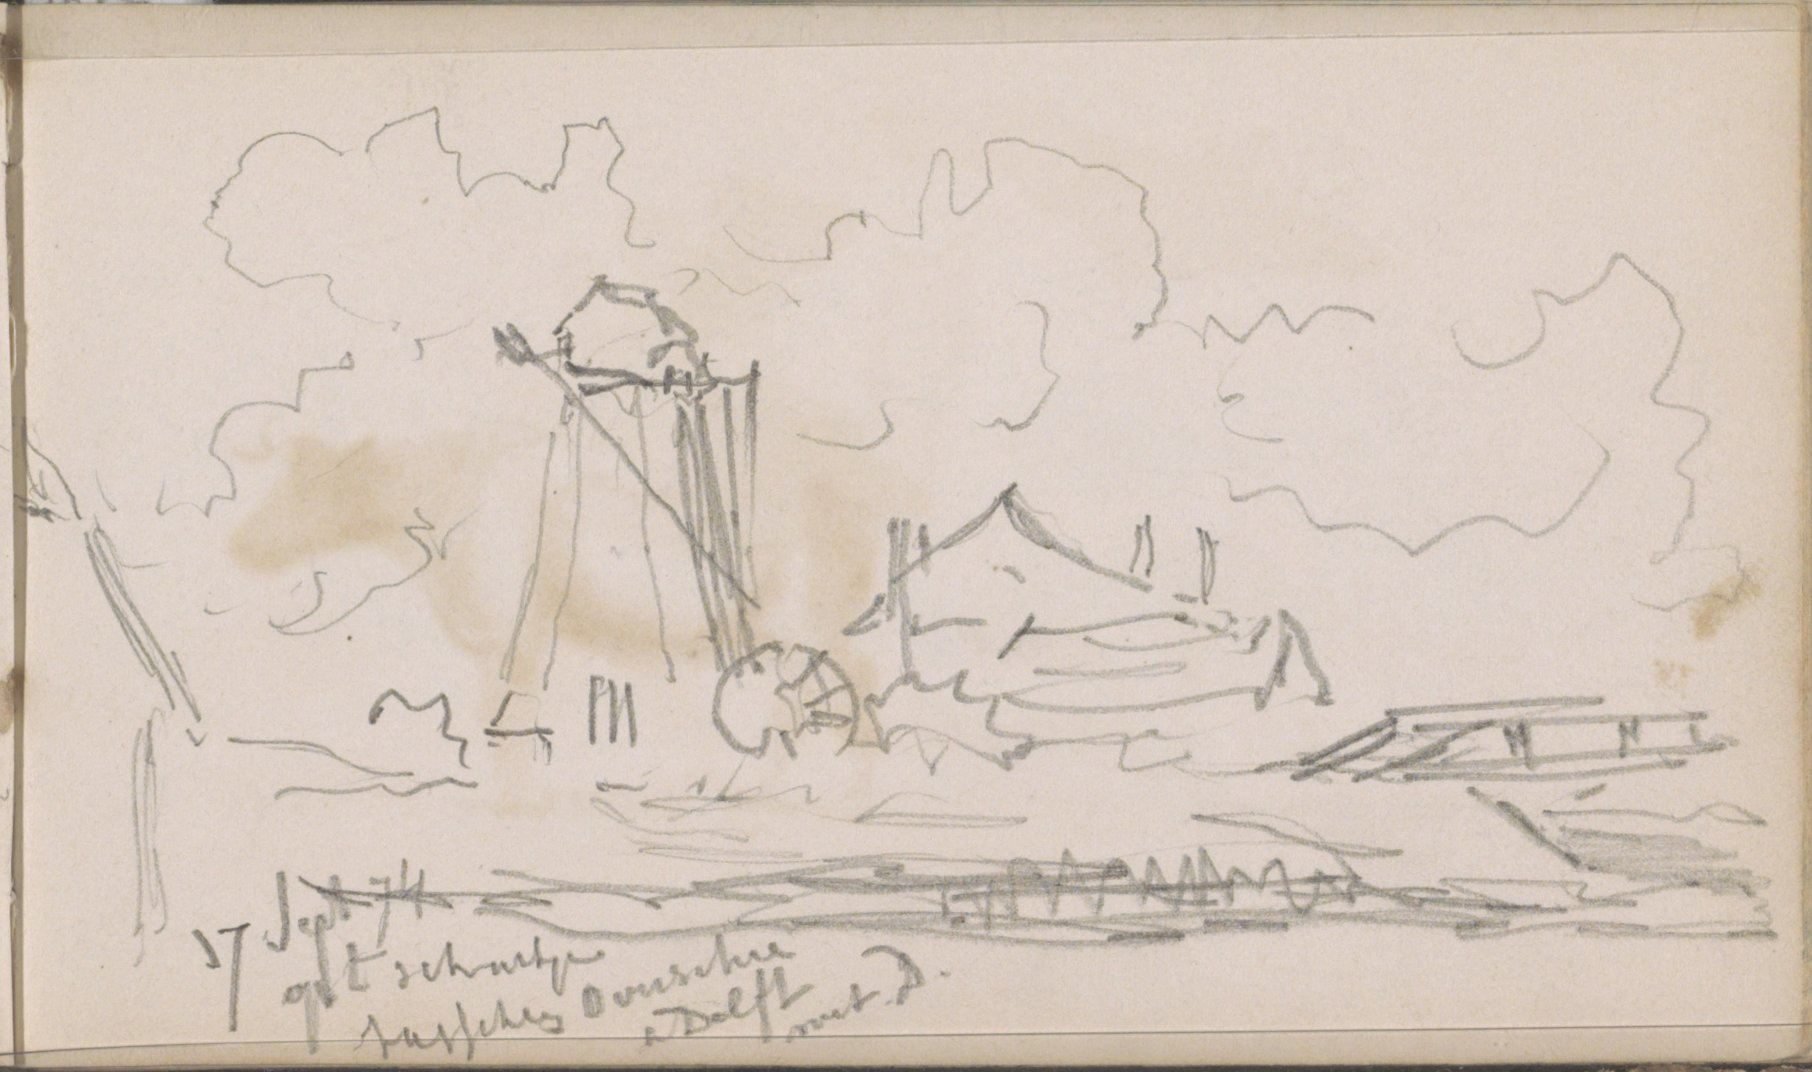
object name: sketchbook leaf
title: Liggende koeien in een weiland bij Hillegersberg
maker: johannes tavenraat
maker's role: draughtsman, painter, print maker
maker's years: 1809-1881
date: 1806-1874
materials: ink, paper, pencil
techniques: pen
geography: hillegersberg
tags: cow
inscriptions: date and inscription: ‘op weg naar Hillegersberg met Dirk waar koffij gedronken/ 8 Juni 74 Op gestaan voor 't af was/ maar deze koe had kop &/ hals alom afgewend/ Kralingsche veer St Jan 1874/ Rotterdam/ Dat Lamberts naam in Kralingen des/ Burgemeesters moog wezen/ Langer dan de weg van deze gemeente/ oud is tot dagen/ J. T[...]/ 11. Juni bij 't Hooft/ 12. Juni met/ Dirk gewandeld/ Jan Muilwijk/ bezzocht & in de/ plantage koffij/ gedronken niets/ geteekend [...]/ guur weer/ p. br. kaart verzonden/ den 23 Juni 74 aan 't adres/ v.d. Heer Dekker. Kralingsche Veer.’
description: Blad 25 recto uit een schetsboek met 46 bladen.